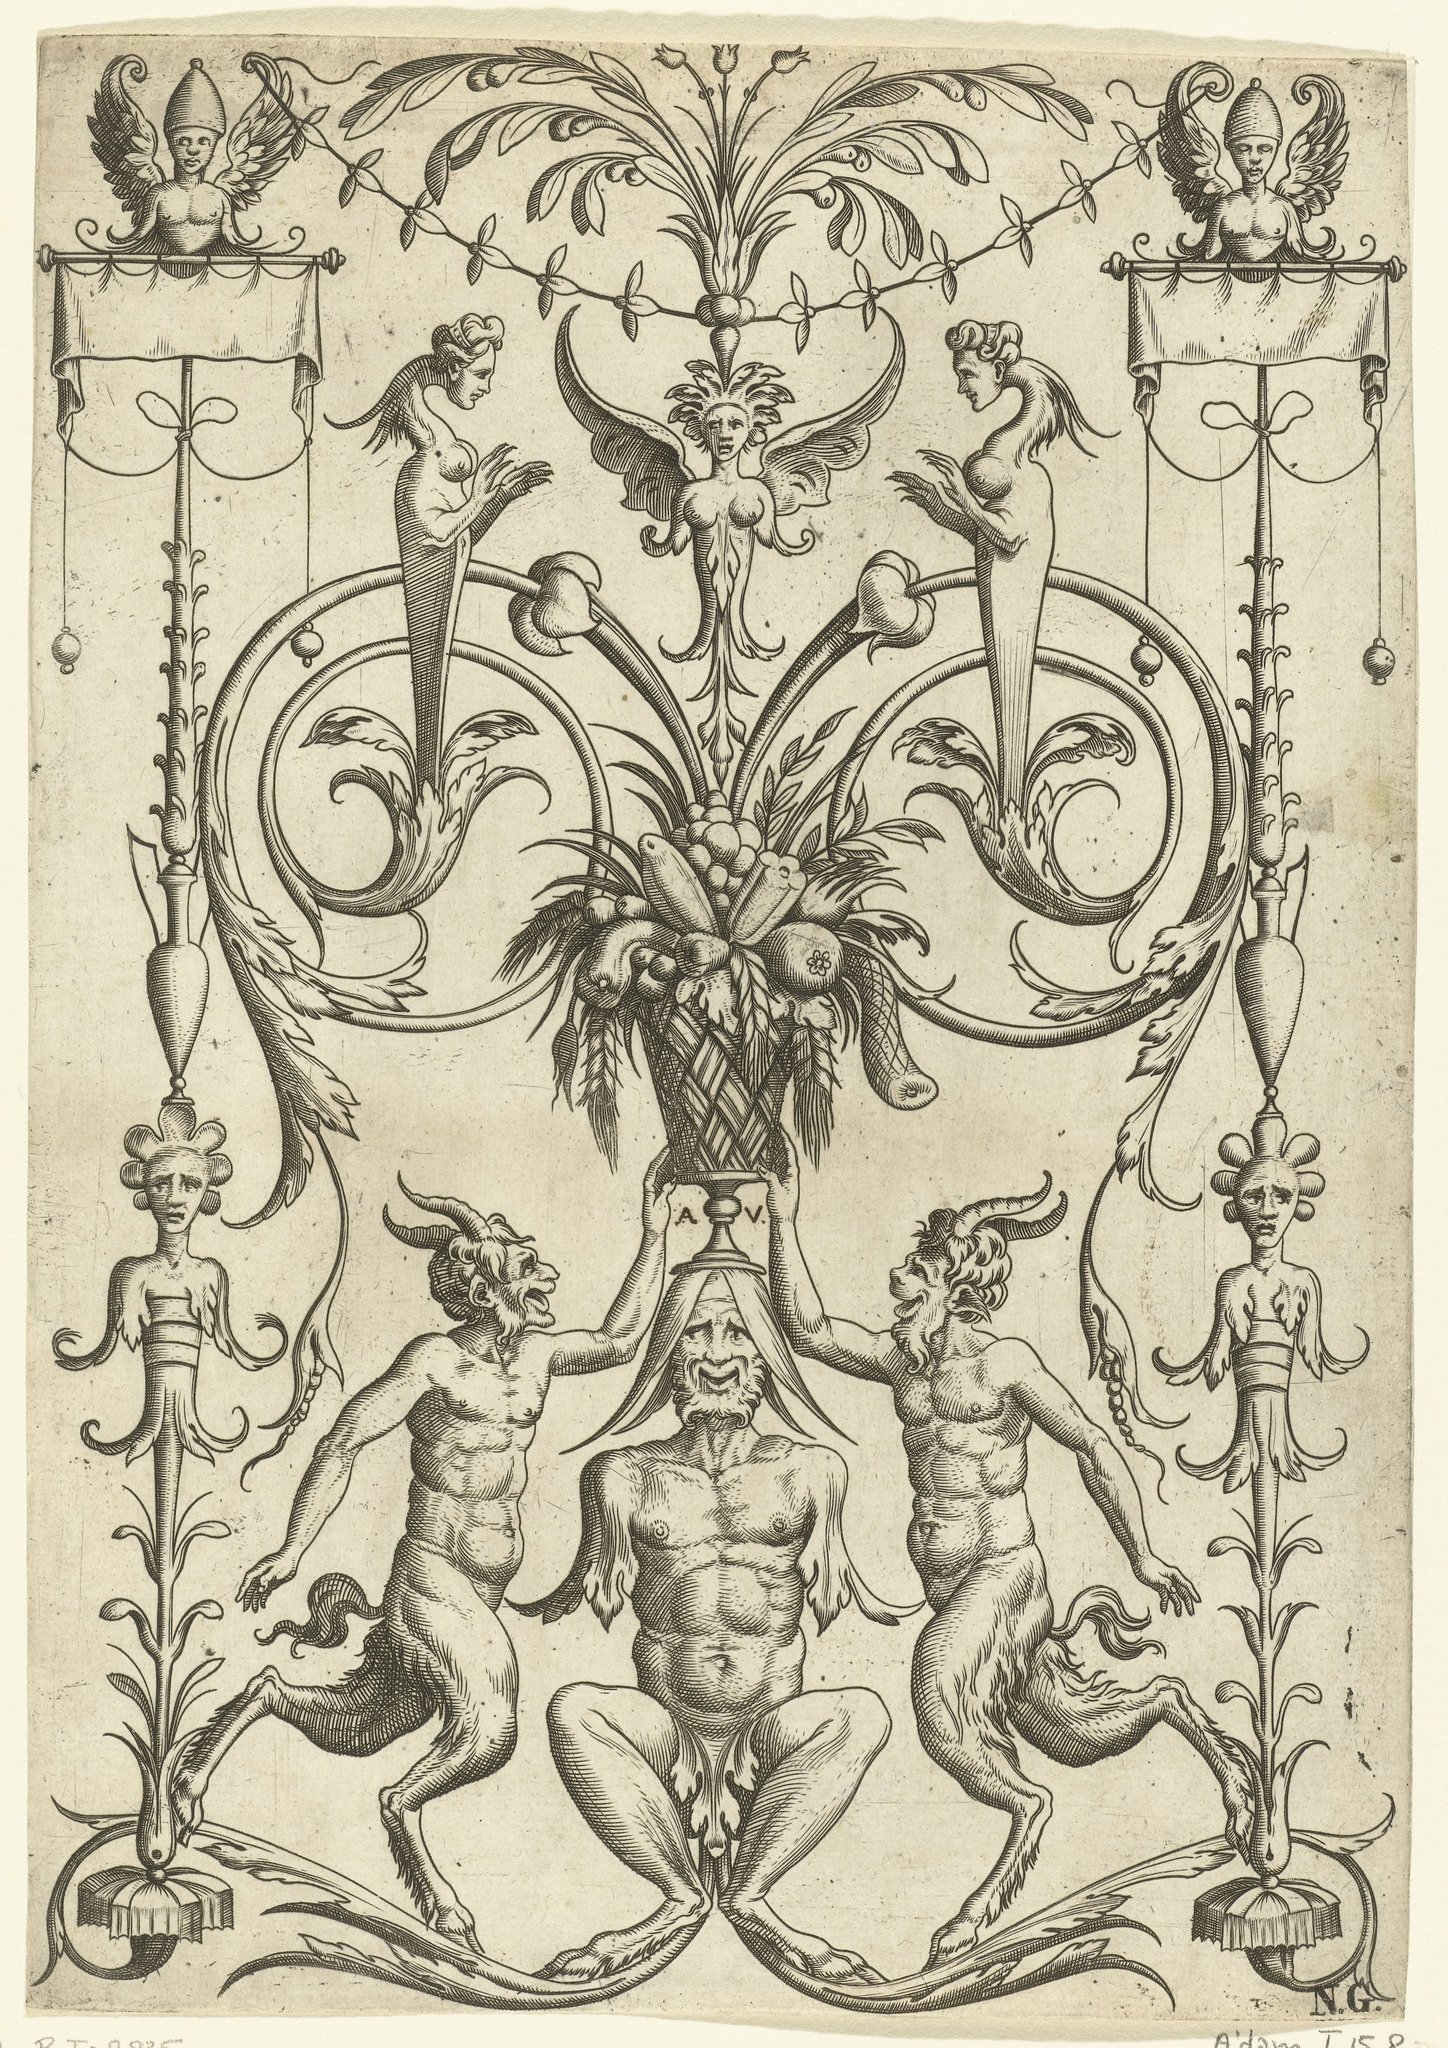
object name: print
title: Gehurkte sater zonder armen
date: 1516-1556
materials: paper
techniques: engraving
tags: ornament ~ grotesque, fruits and vegetables ~ ornament, satyr(s) (in general)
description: Een gehurkte sater draagt op zijn hoofd een mand met fruit, daarbij geholpen door twee saters die elk met één hand de mand ondersteunen. Blad uit serie van 9 bladen.